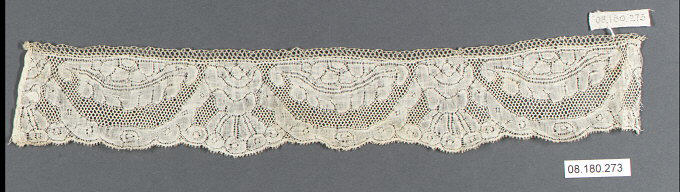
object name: fragment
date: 1767-1800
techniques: lace